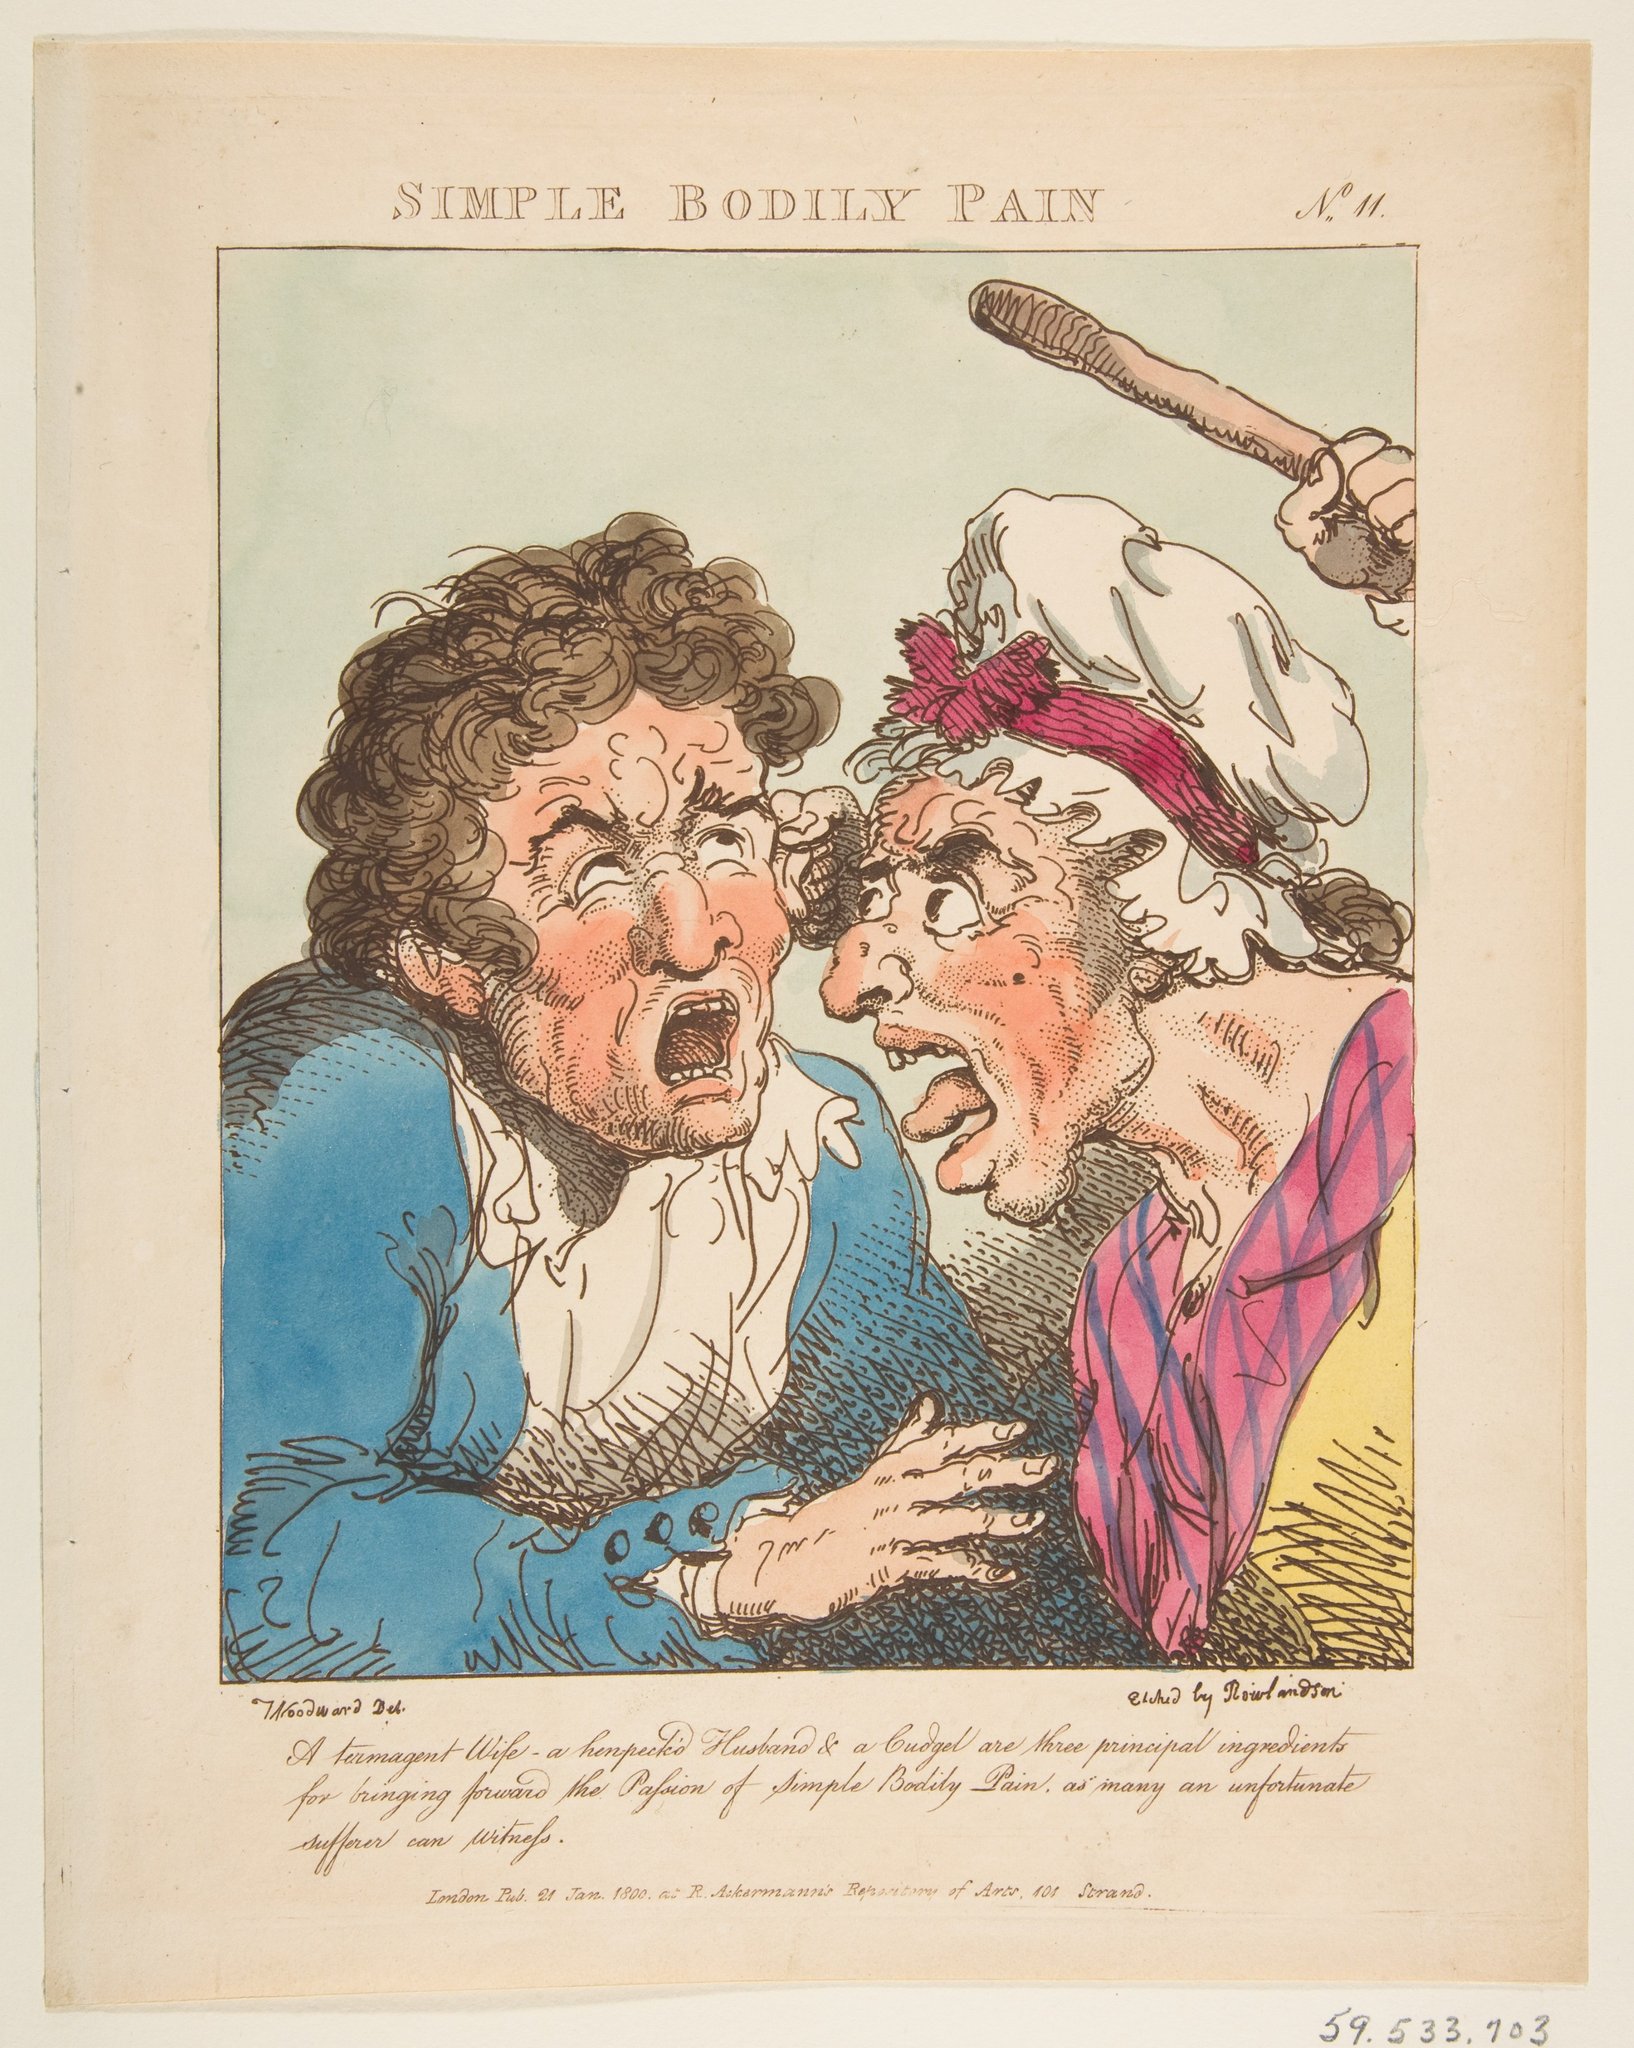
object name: print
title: Simple Bodily Pain (Le Brun Travested, or Caricatures of the Passions)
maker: thomas rowlandson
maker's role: artist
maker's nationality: british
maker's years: 1757-1827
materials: ink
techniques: etching, printing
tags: satire,men